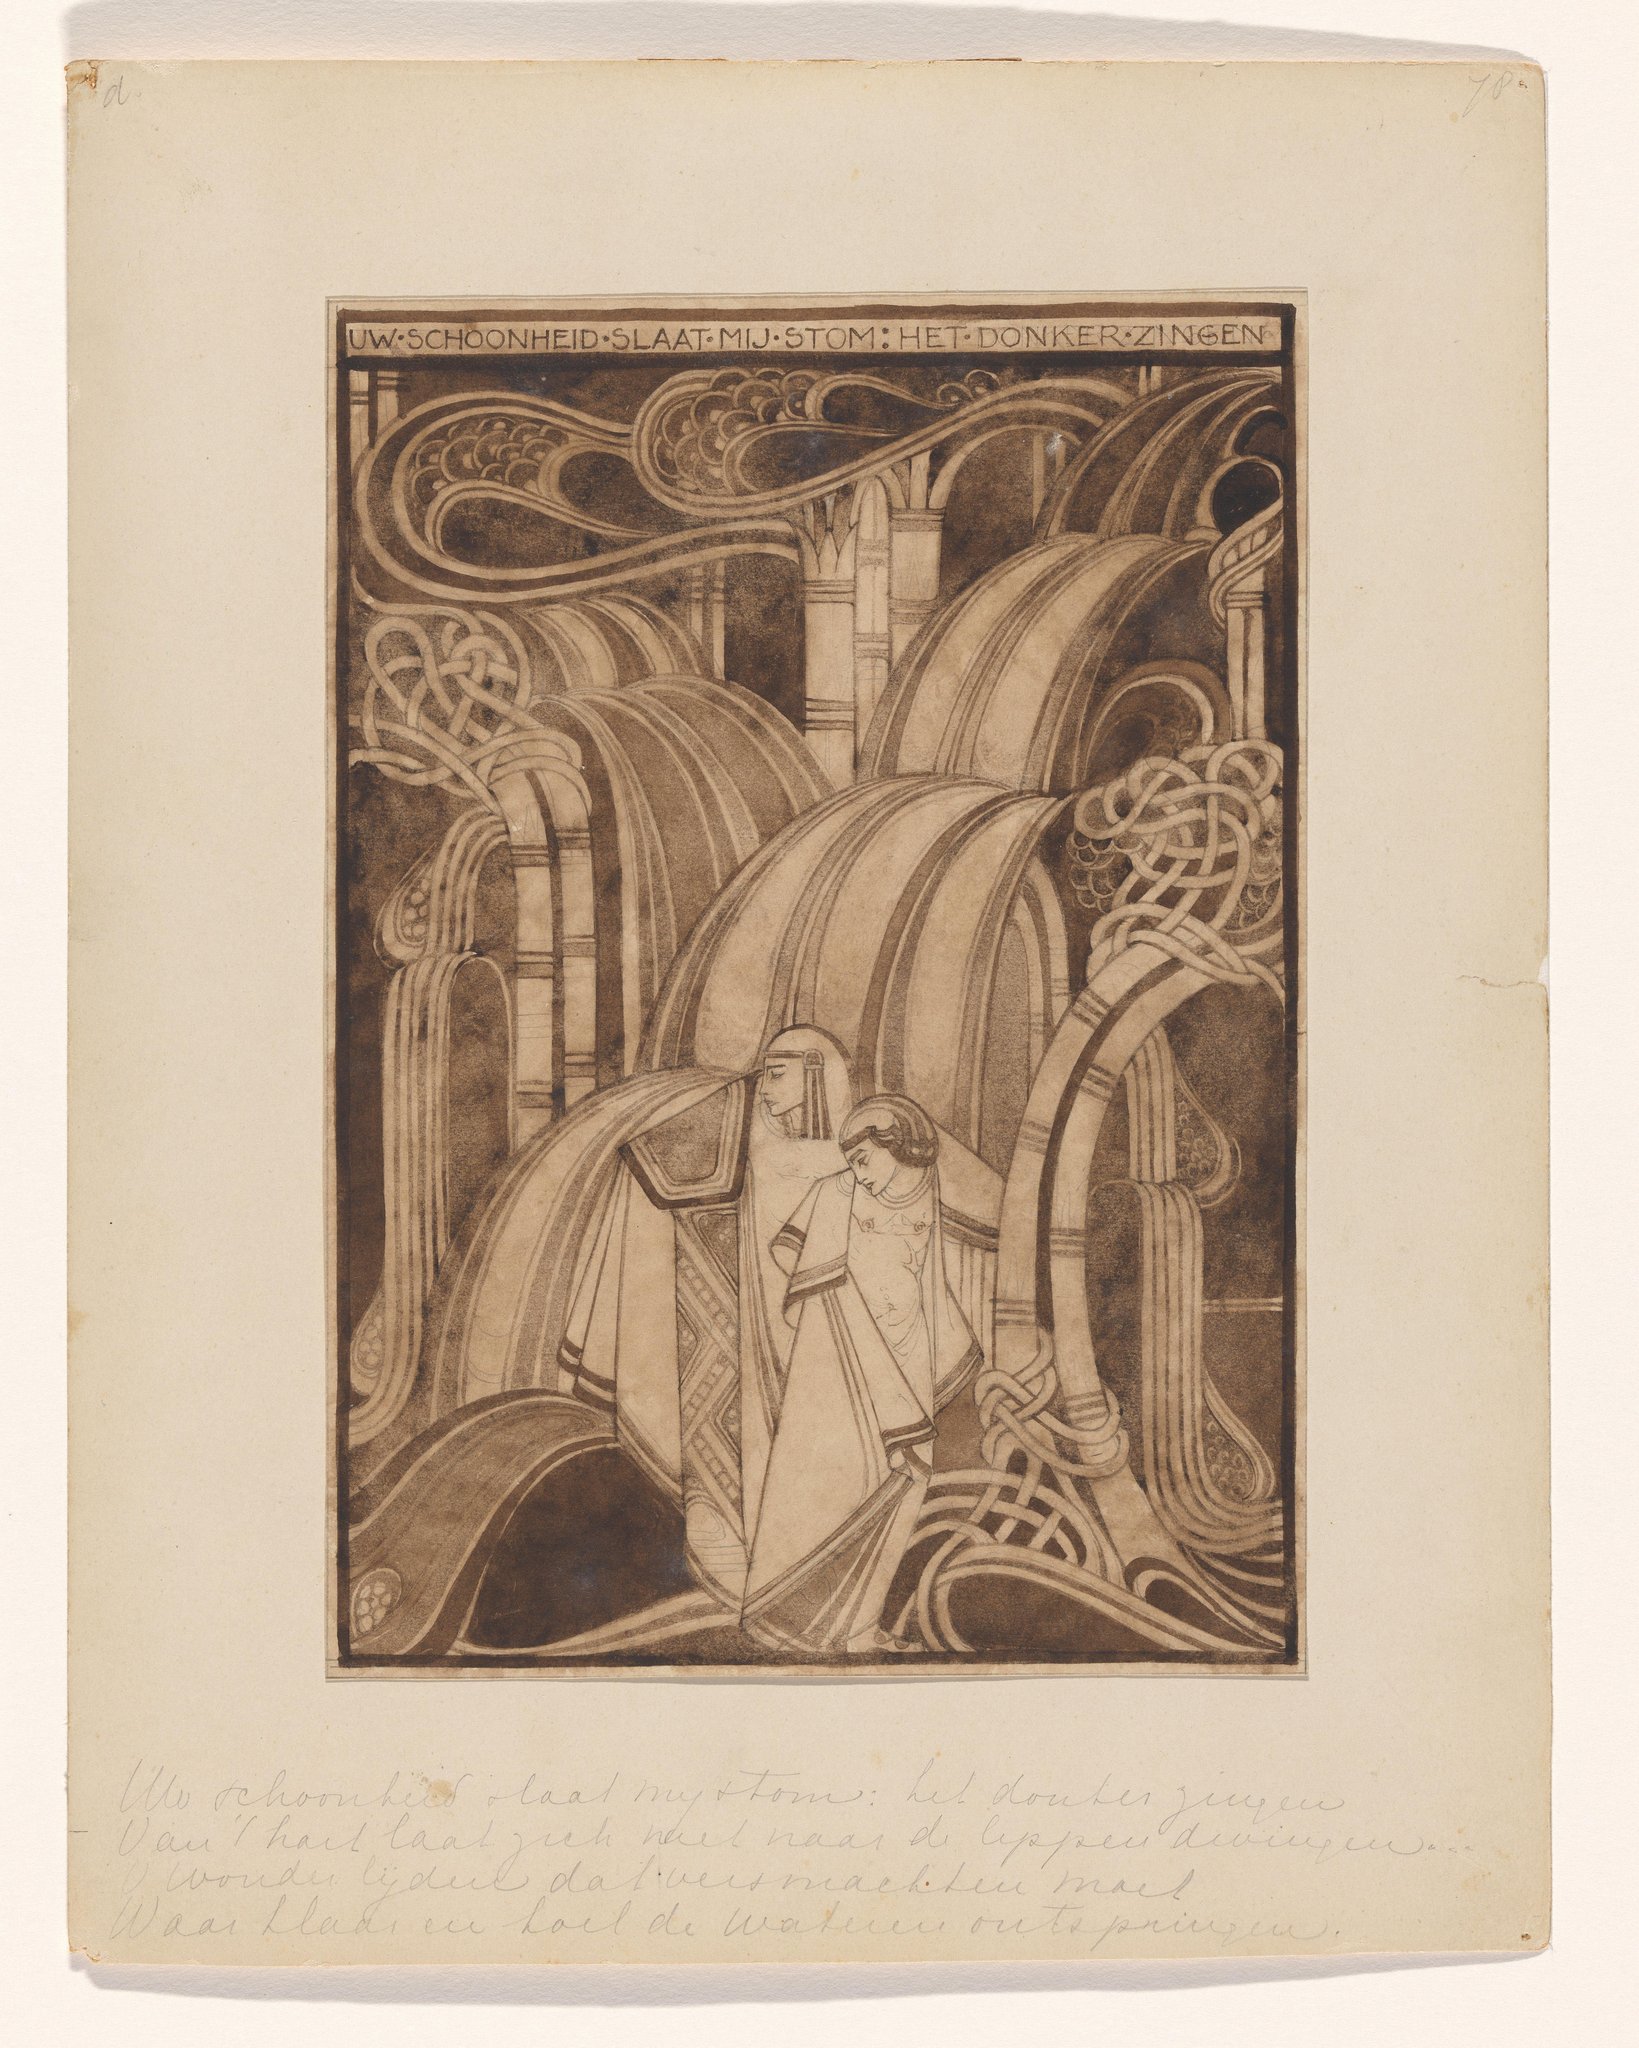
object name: drawing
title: Uw schoonheid slaat mij stom: het donker zingen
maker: willem arondéus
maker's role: draughtsman, print maker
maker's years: 1894-1943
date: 1914-1920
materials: cardboard, ink, paper, pencil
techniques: brush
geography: netherlands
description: Tekening naar de Rubaiyat van Omar Khayyam.